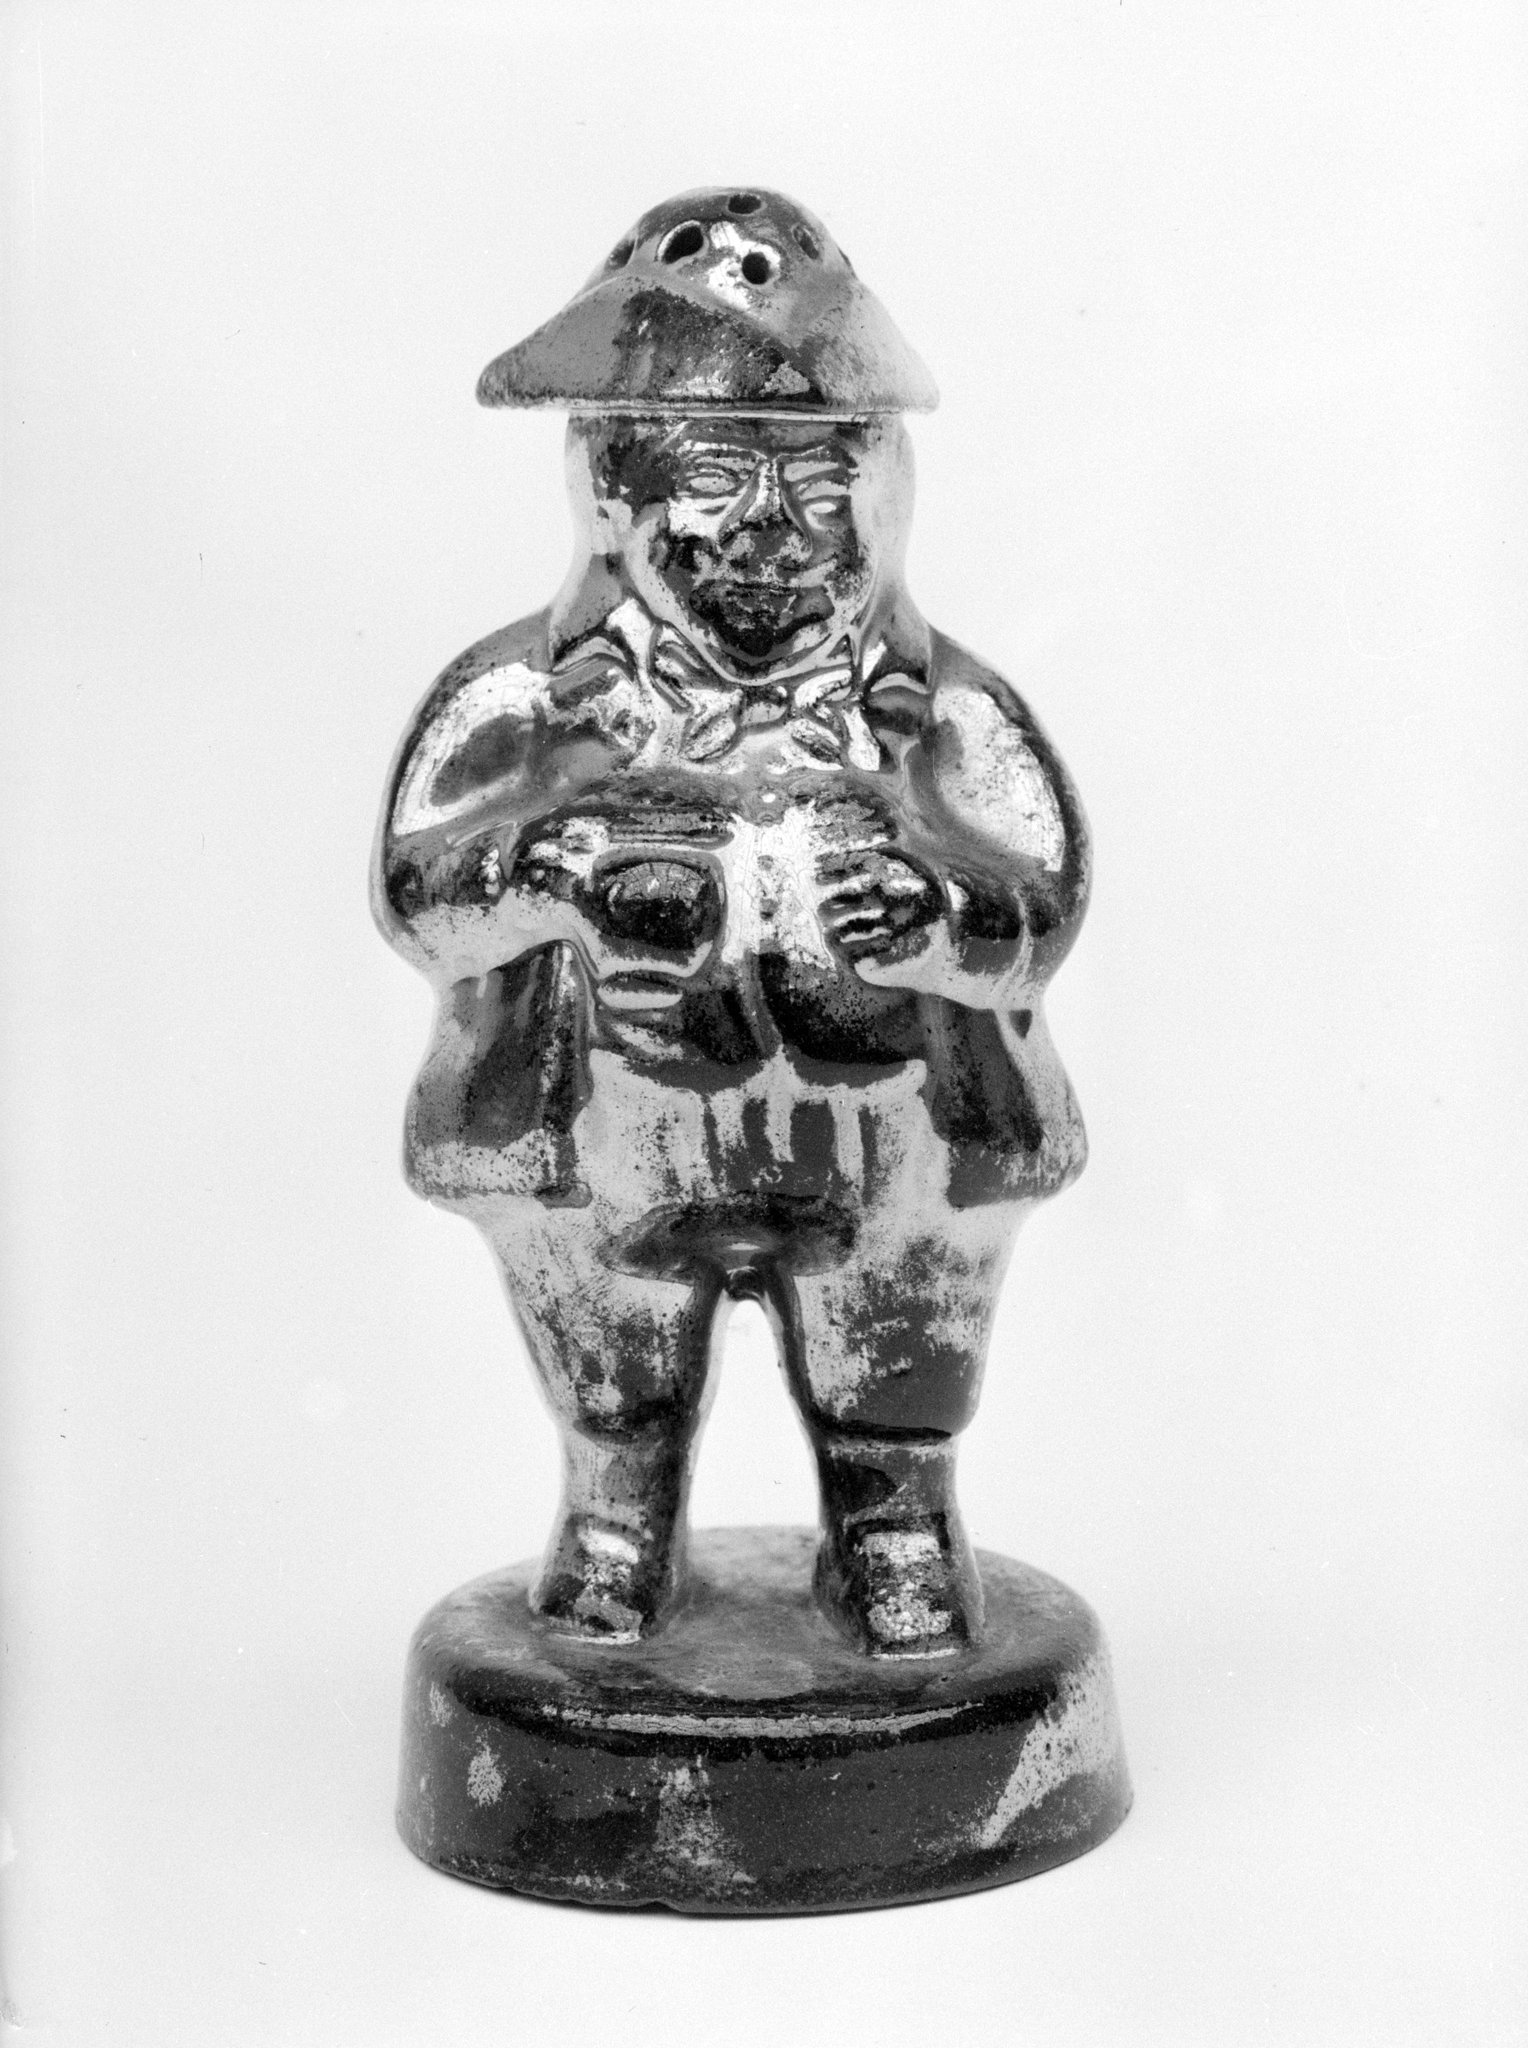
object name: caster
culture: british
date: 1800-1830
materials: earthenware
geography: england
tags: men